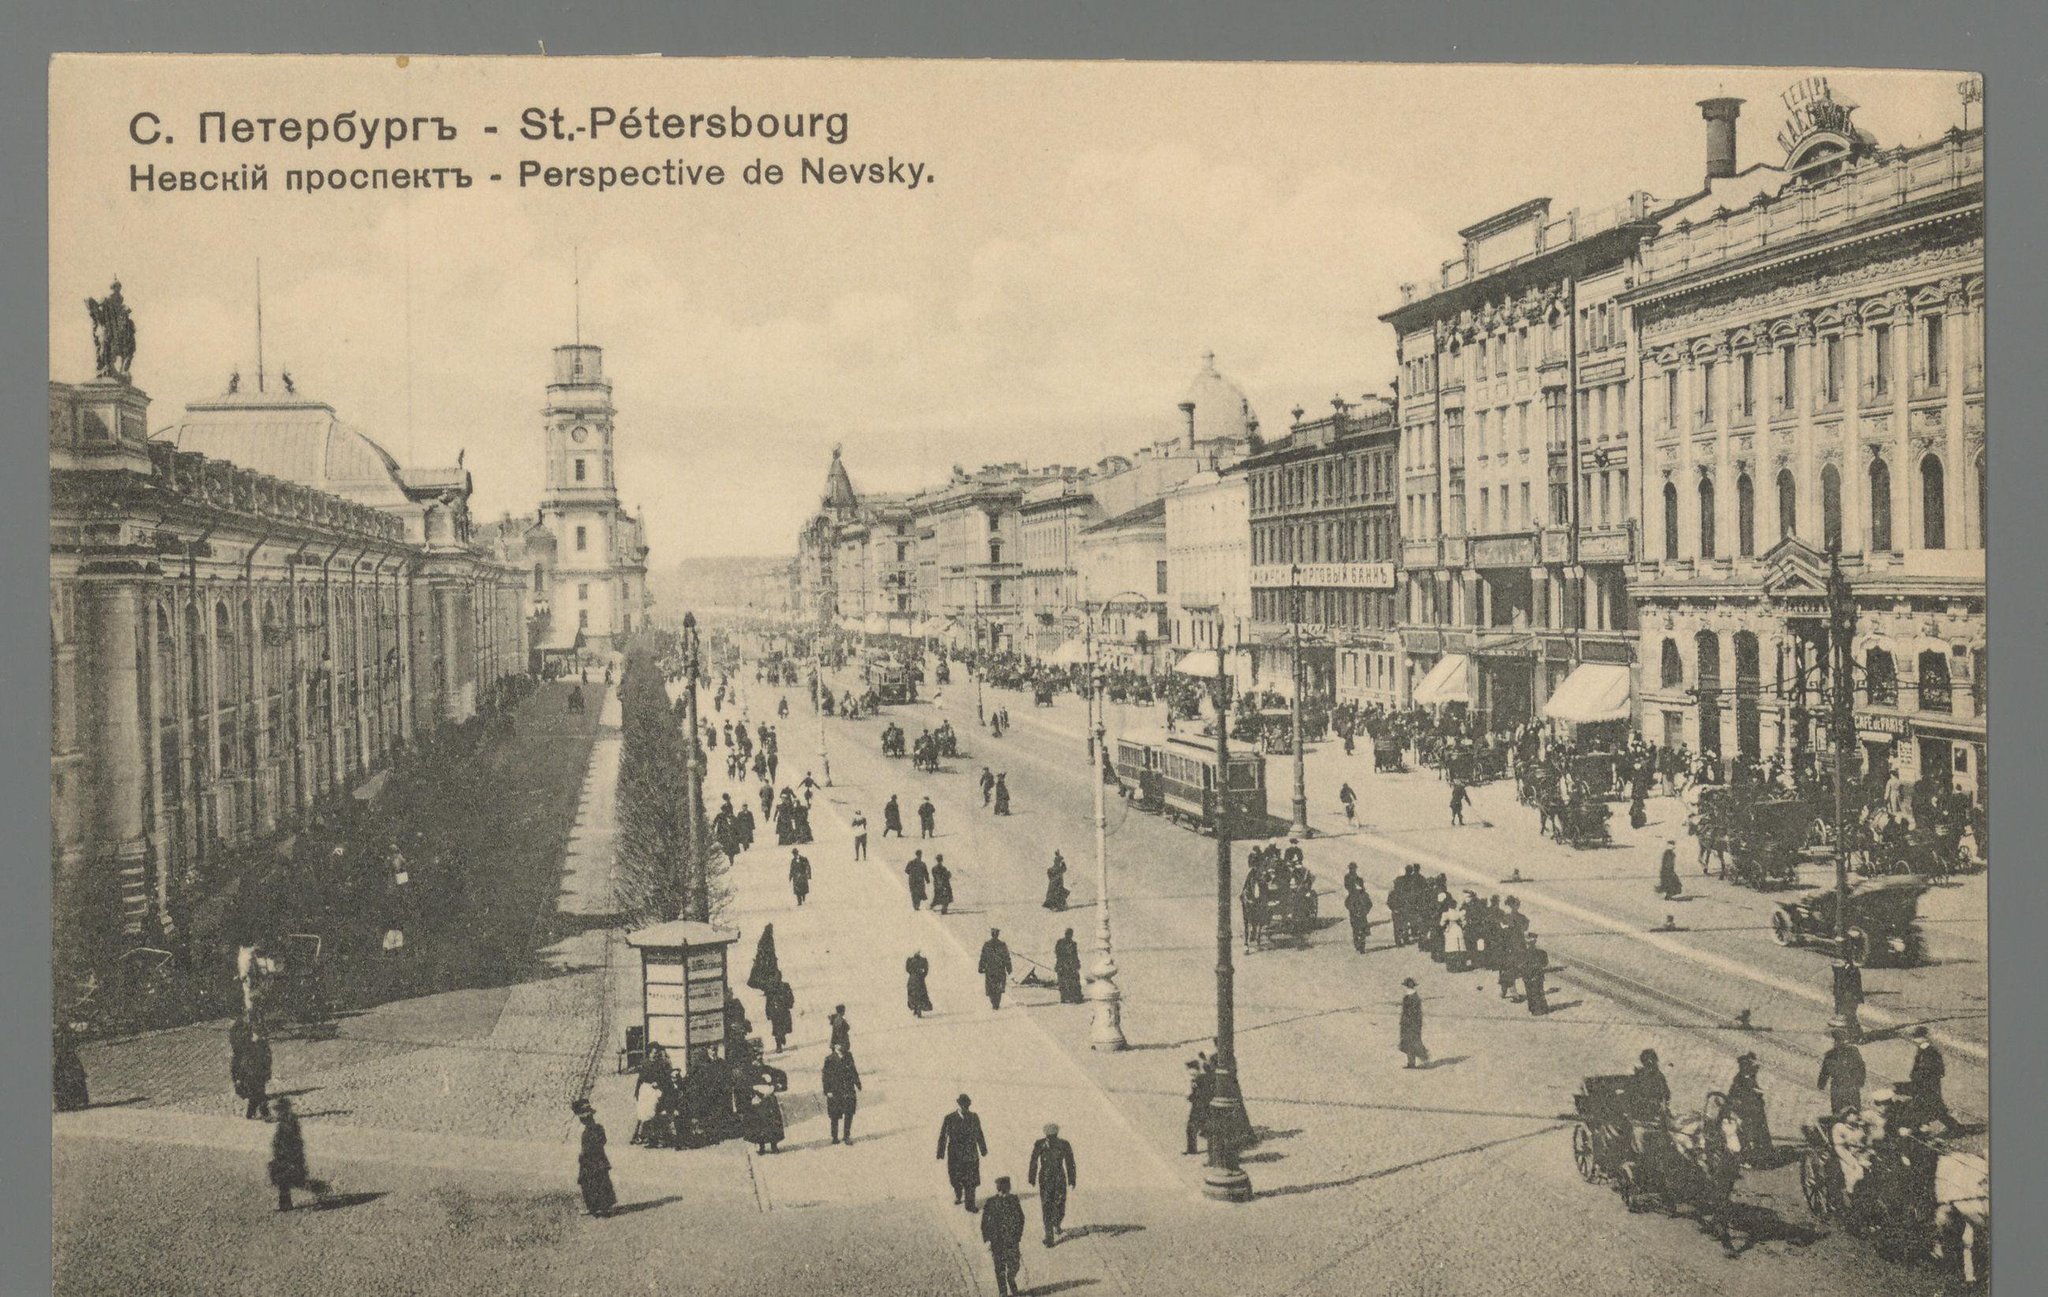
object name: photomechanical print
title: St.-Pétersbourg. Perspective de Nevsky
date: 1904-1930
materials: cardboard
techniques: photograph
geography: sint-petersburg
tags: square, place, circus, etc., tram, poster-pillar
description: Voor de Franse titel staat de titel in het Russisch.